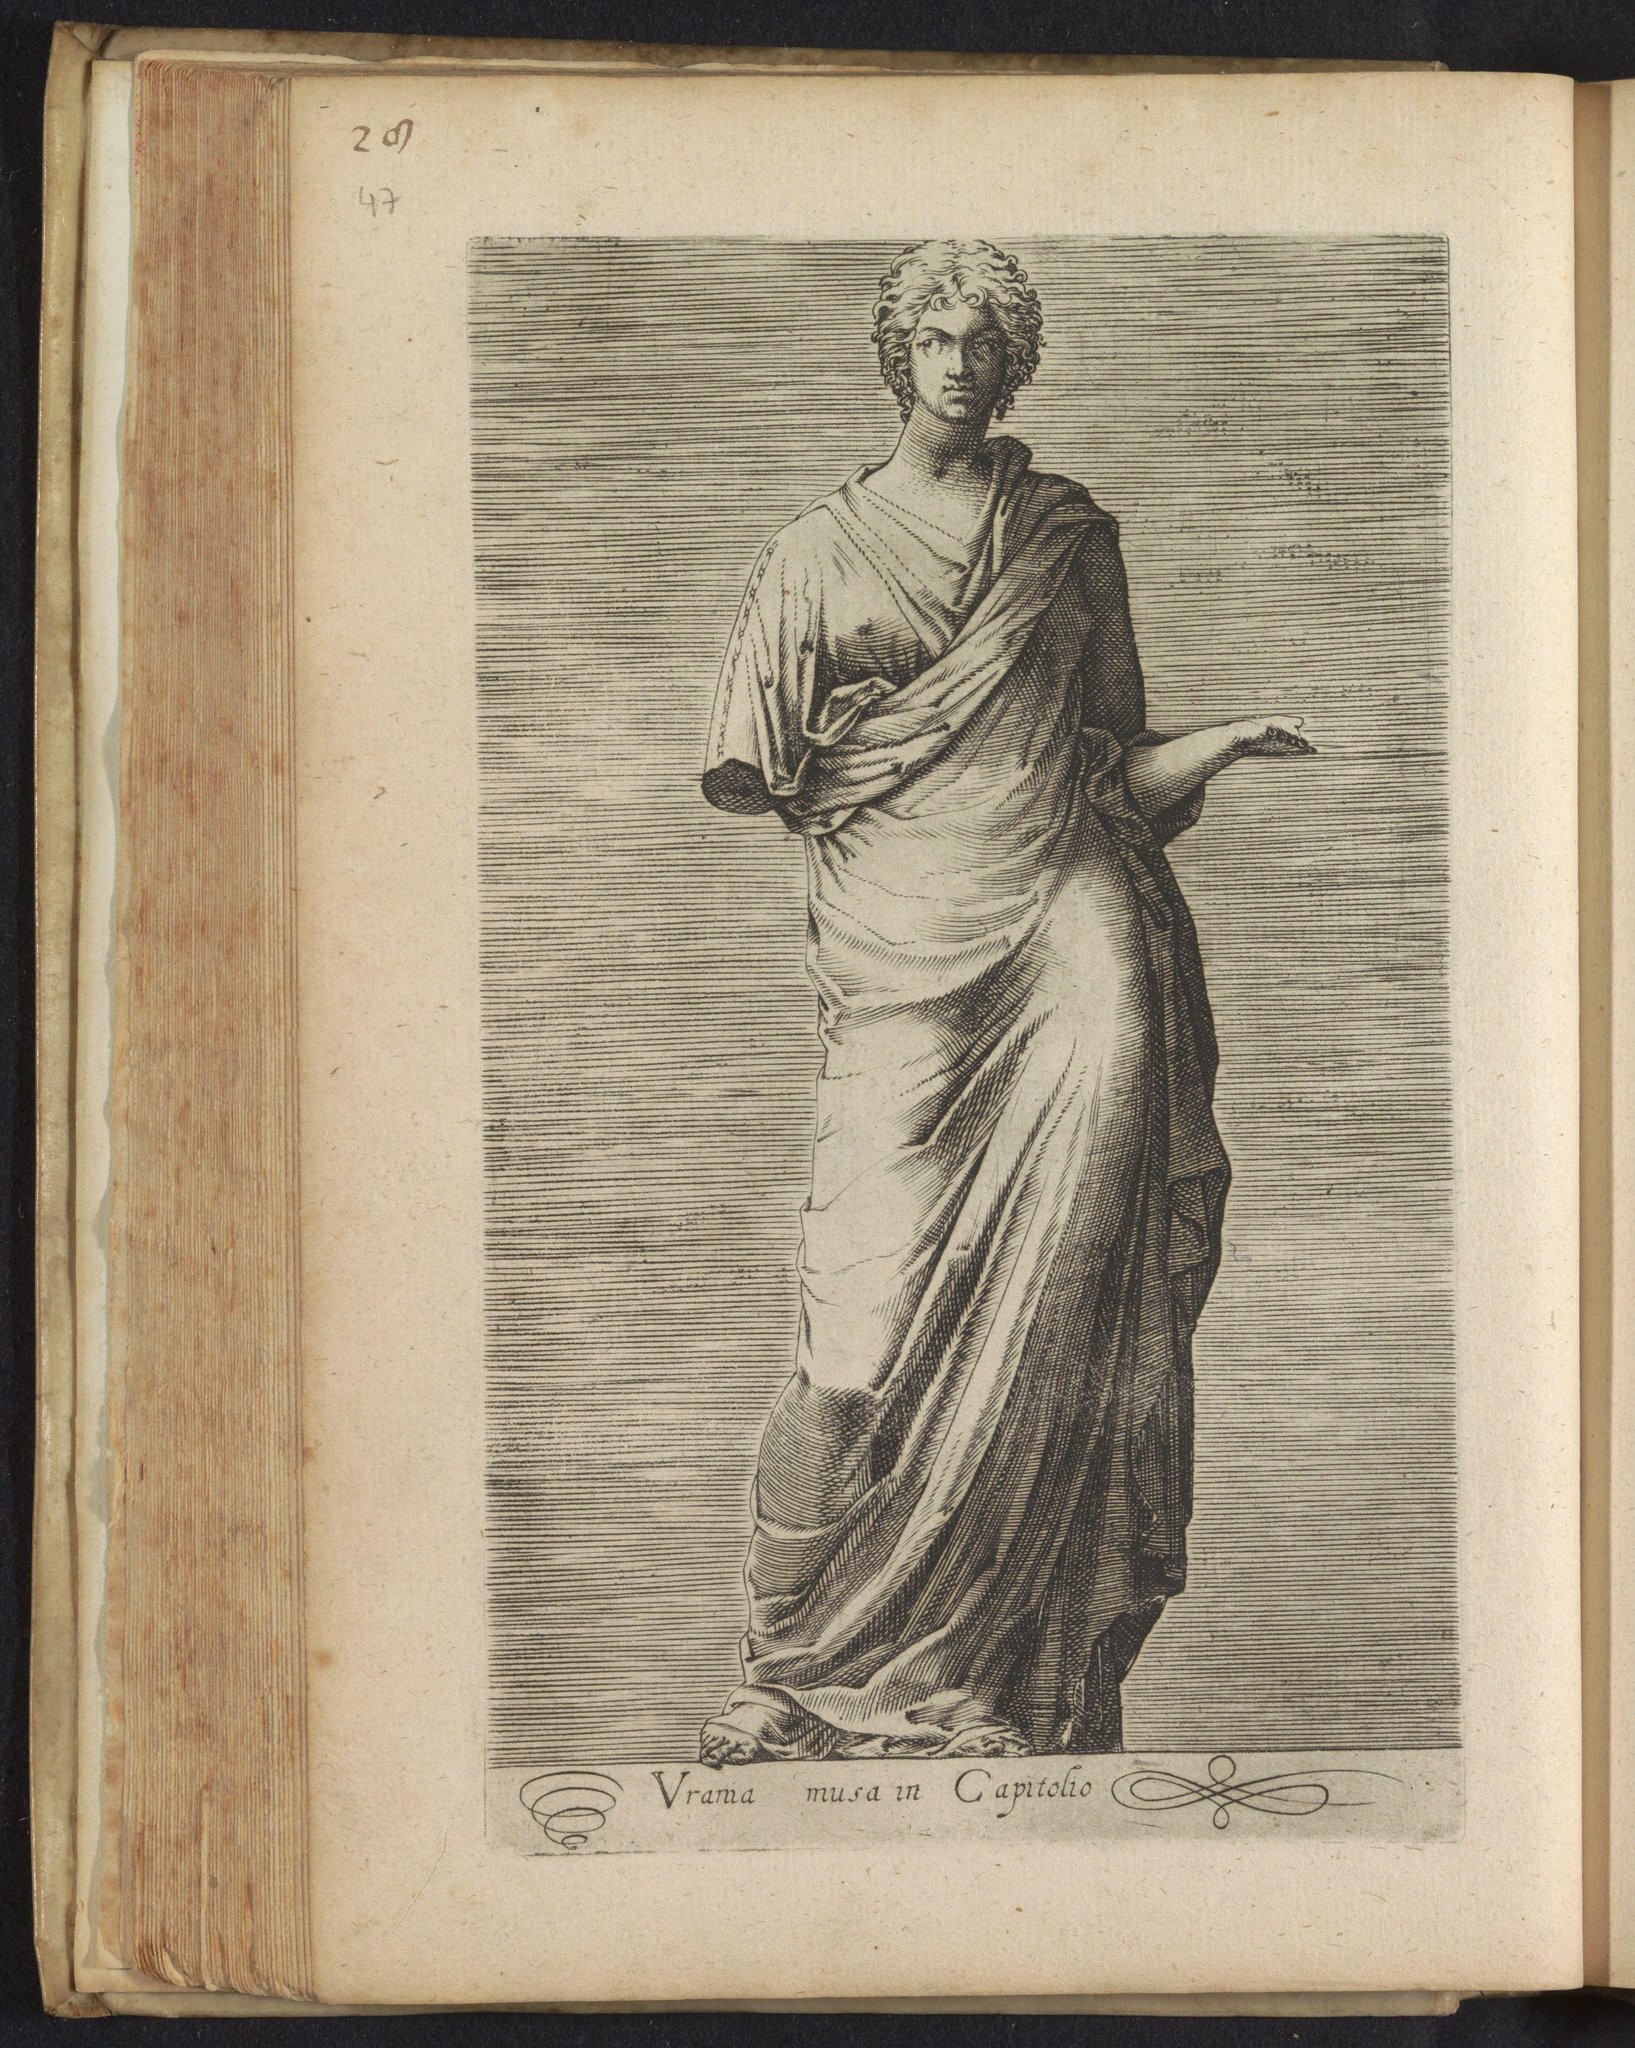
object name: print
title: Sculptuur van Urania, muze van de sterrenkunde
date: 1584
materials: paper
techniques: engraving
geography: italy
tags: piece of sculpture, reproduction of a piece of sculpture, urania (one of the muses); 'urania' (ripa)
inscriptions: number: ‘28’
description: Deze prent maakt deel uit van een set van 79 prenten (+ titelprent) met voorstellingen van antieke sculpturen in Rome.